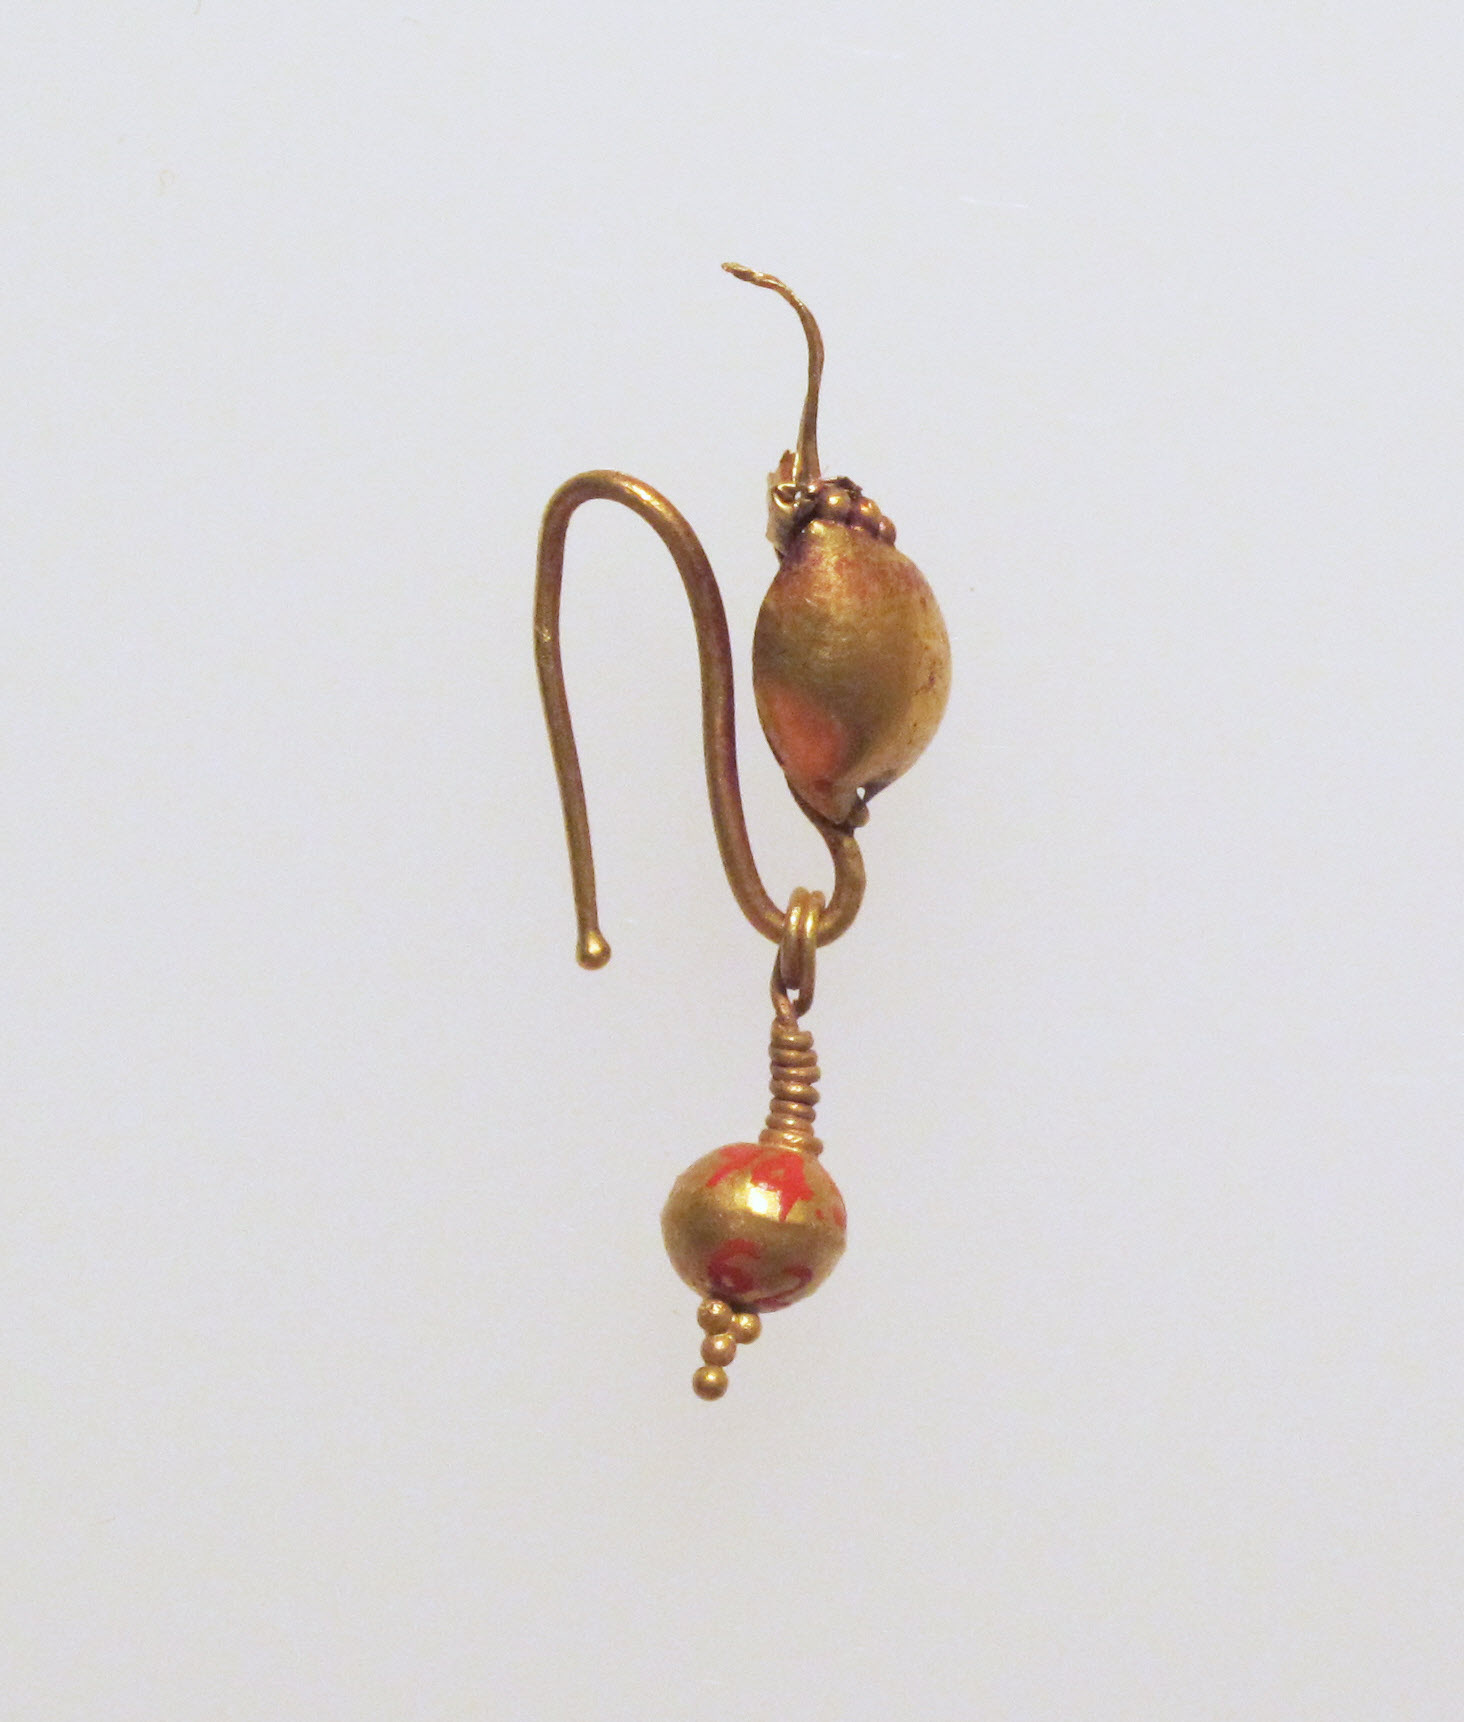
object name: earring with pendant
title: Gold earring with disc and pendant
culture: roman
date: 101-200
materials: gold